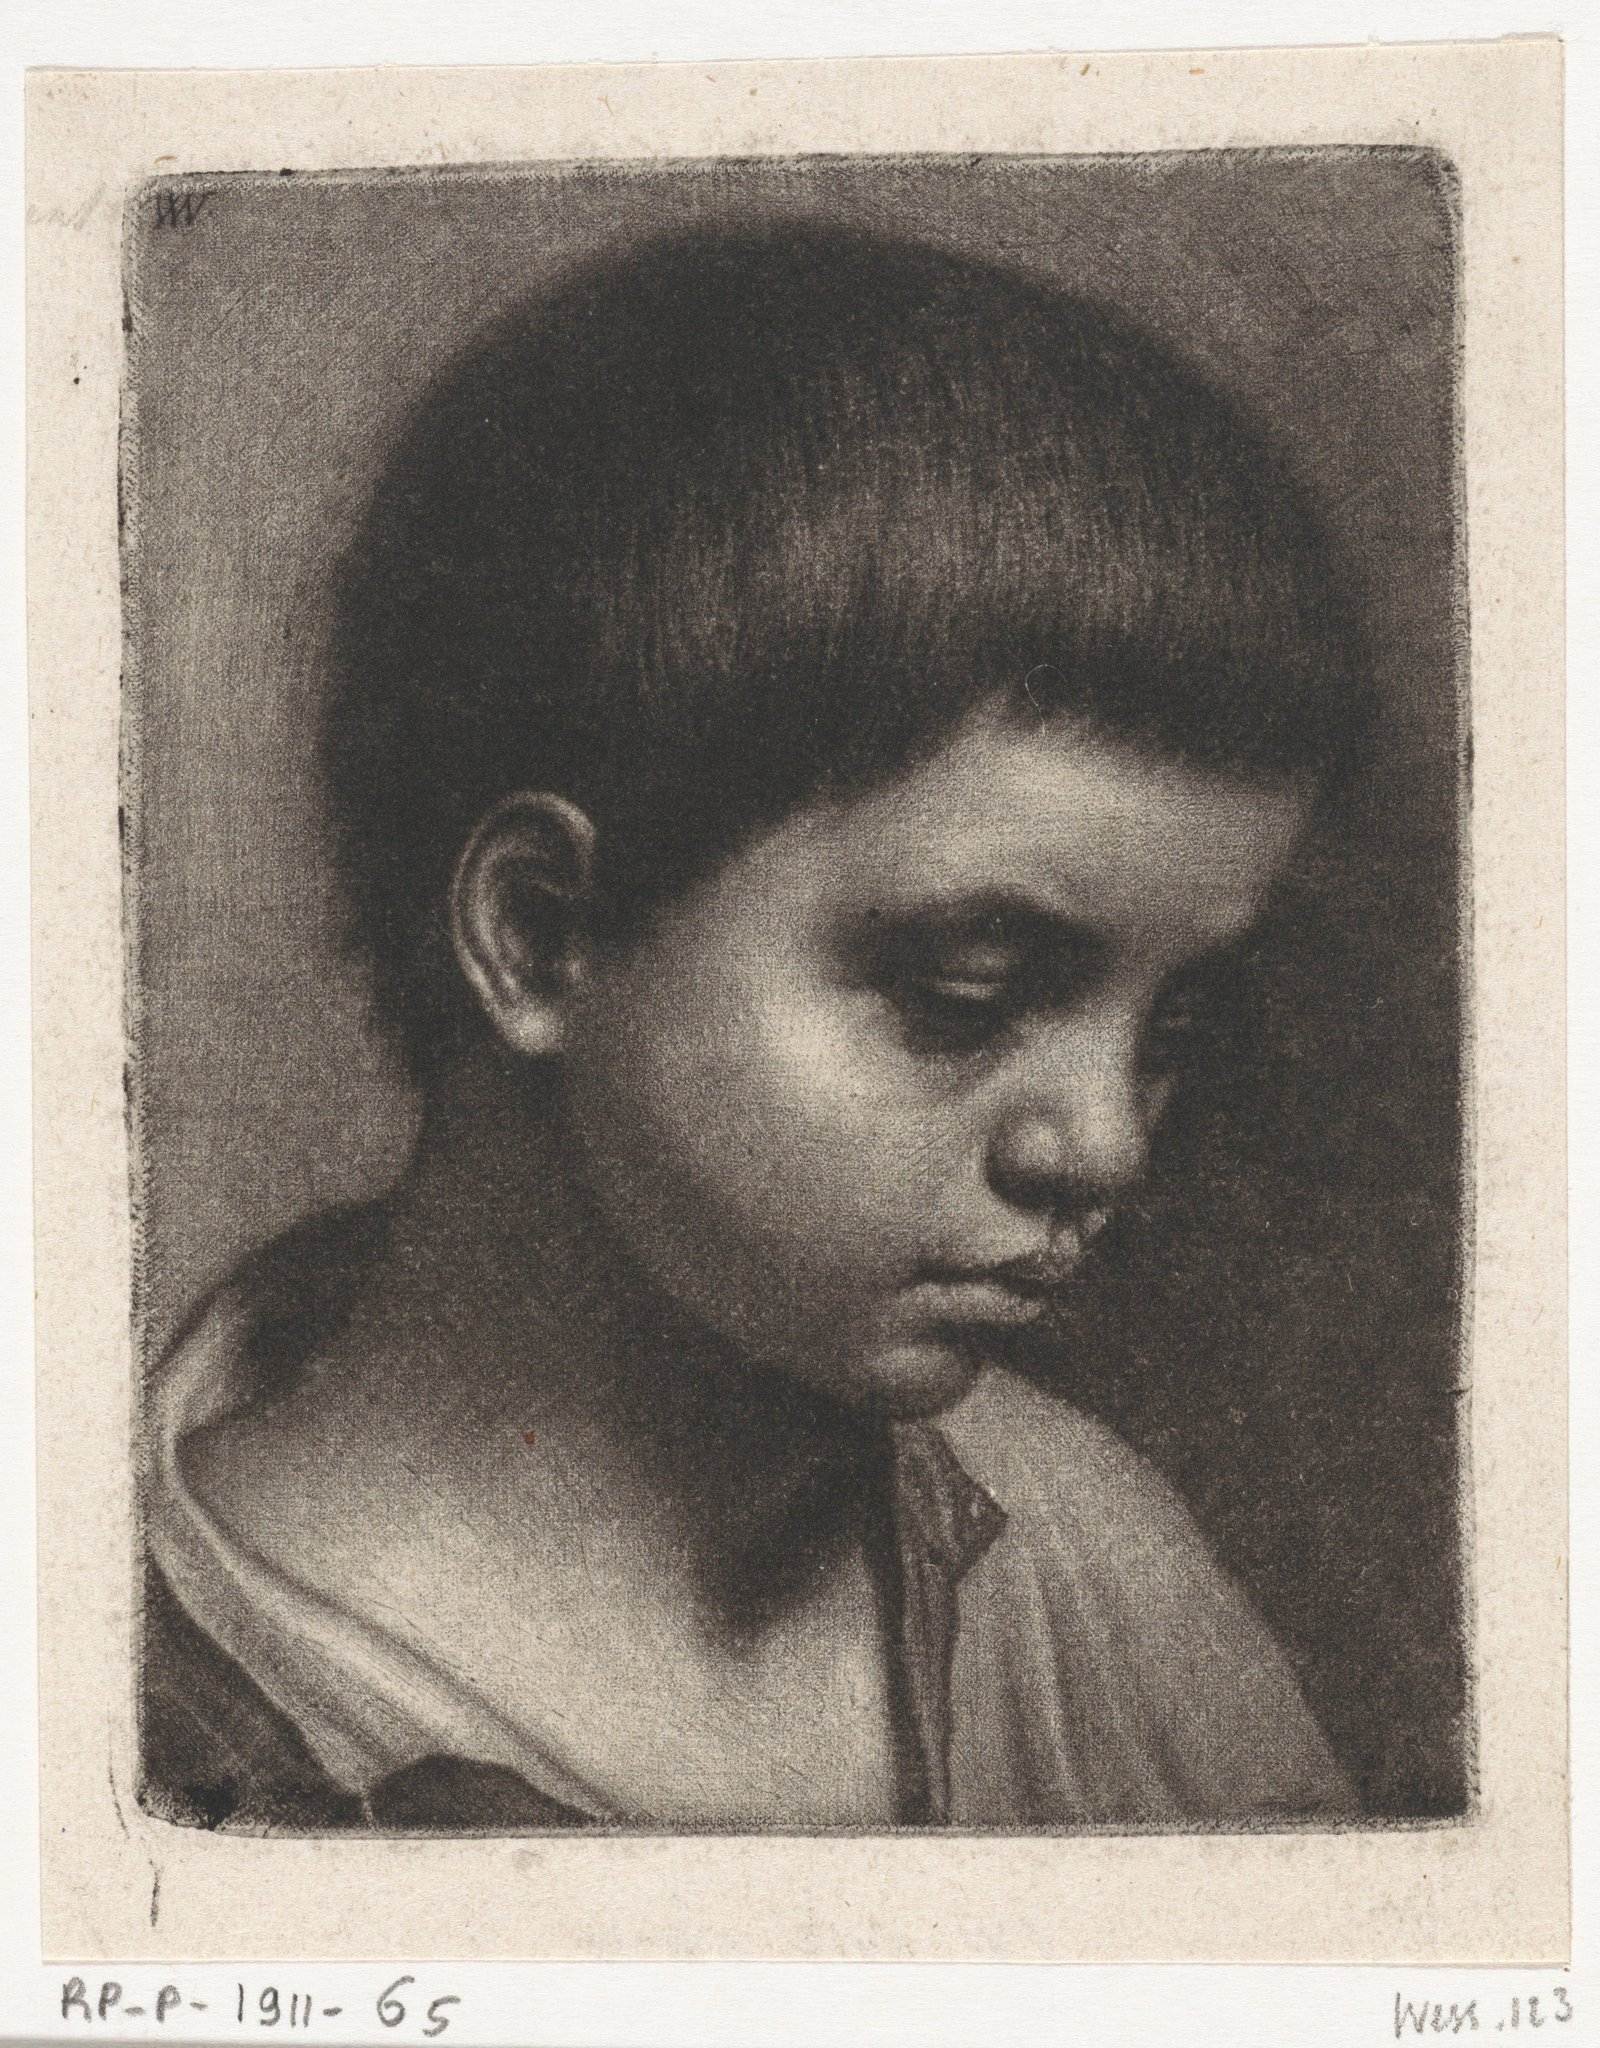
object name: print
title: Hoofd van een jongen, naar rechts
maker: wallerant vaillant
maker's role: draughtsman, painter, print maker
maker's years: 1623-1677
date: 1658-1677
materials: paper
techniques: mezzotint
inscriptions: collector's mark: Lugt 2228